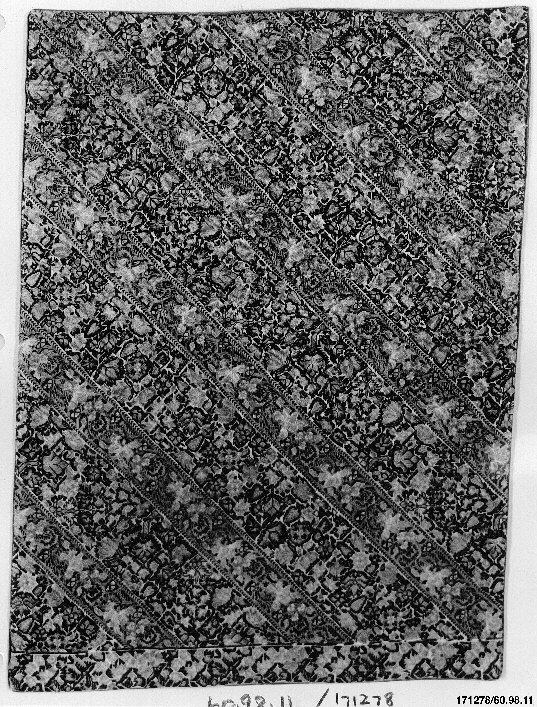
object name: trousering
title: Fragment of Woman's Trousering (Nakshe)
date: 1701-1800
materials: silk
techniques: embroidery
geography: iran